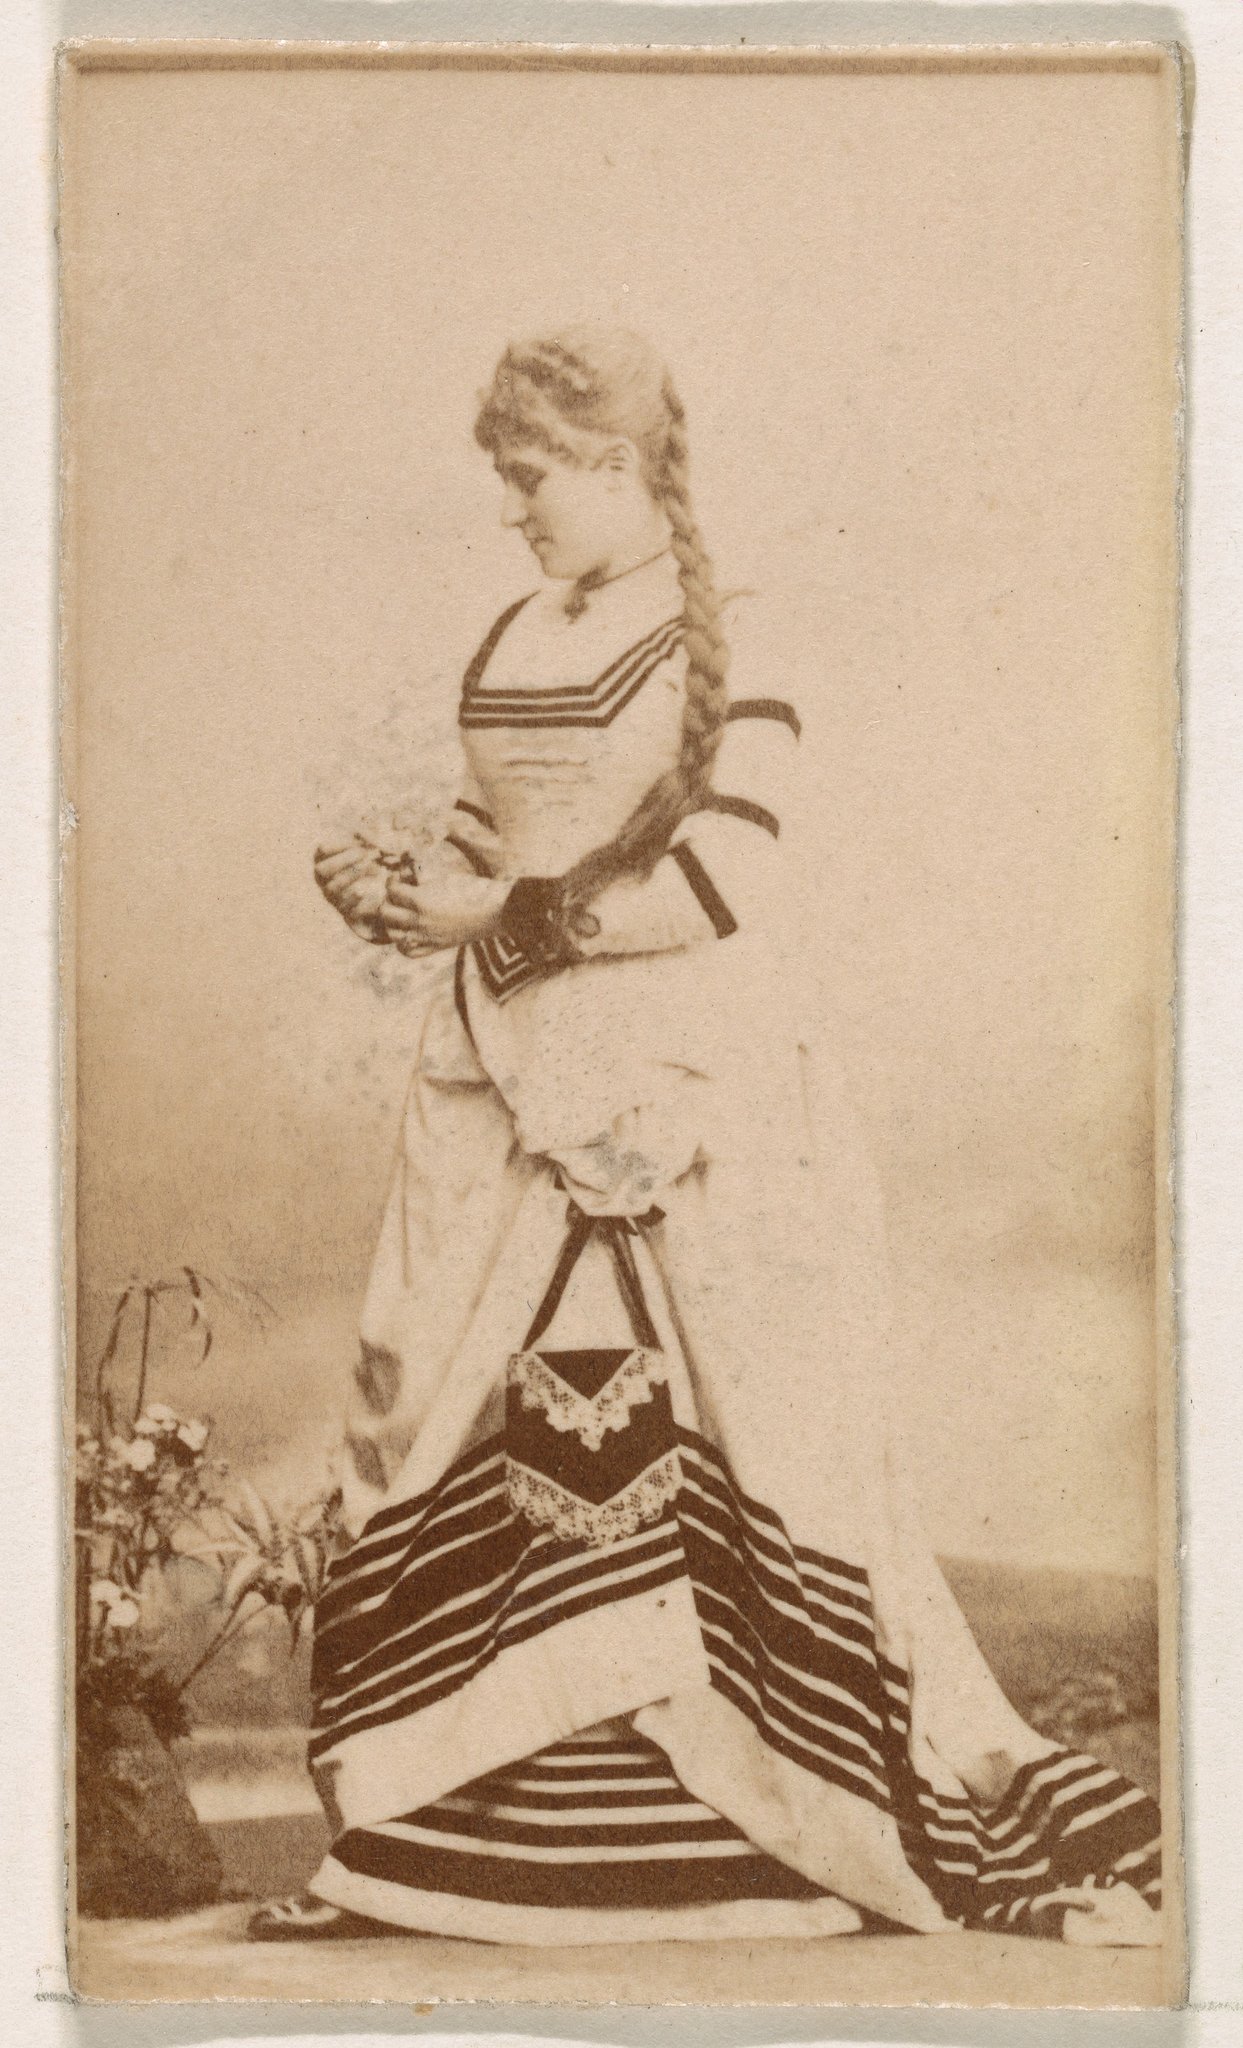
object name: photograph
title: Standing actress in striped gown, from the Actresses series (N245) issued by Kinney Brothers to promote Sweet Caporal Cigarettes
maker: kinney brothers tobacco company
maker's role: publisher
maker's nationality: american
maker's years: 1869-2011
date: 1890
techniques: albumen silver print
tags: women,actresses